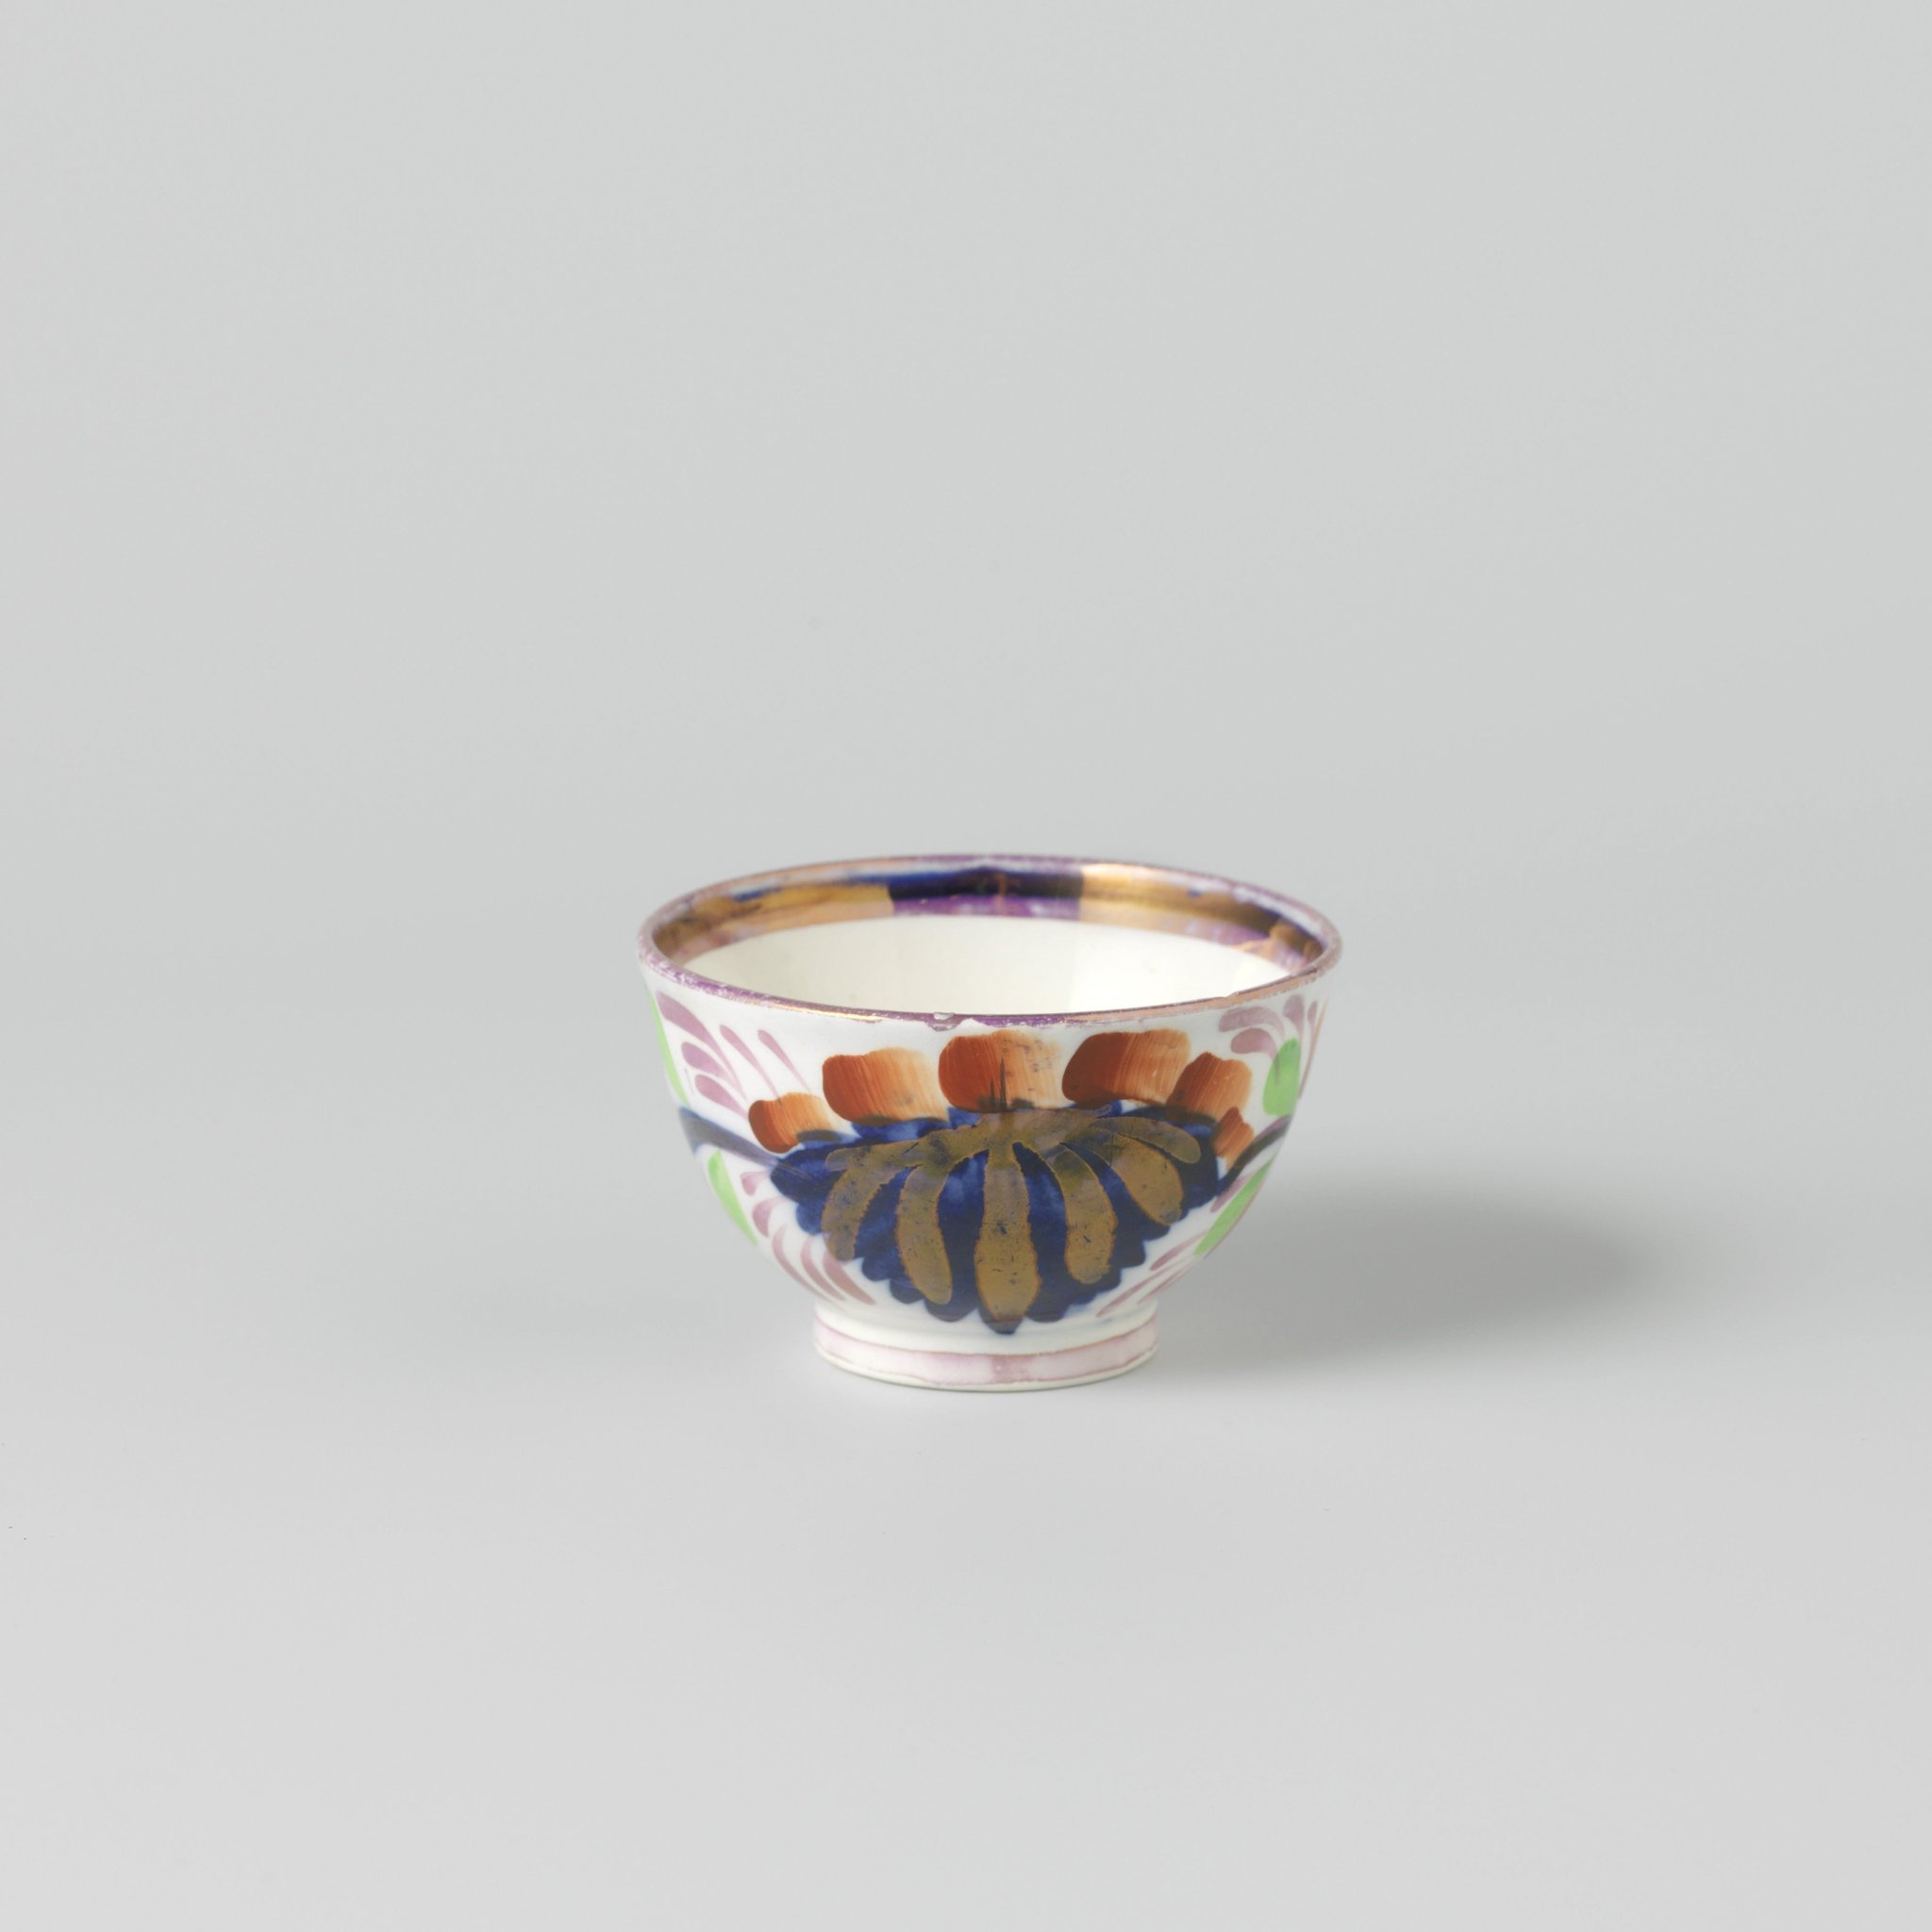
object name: cup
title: Kop met boerenbontdecor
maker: petrus regout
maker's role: plateelbakker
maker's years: 1801-1879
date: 1801-1879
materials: earthenware, glaze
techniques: painted, vitrification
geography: maastricht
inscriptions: check stamp: ‘4’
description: Kop zonder oor van aardewerk, beschilderd met boerenbontdecor in blauw, groen, oranje-rood en lilaluster.